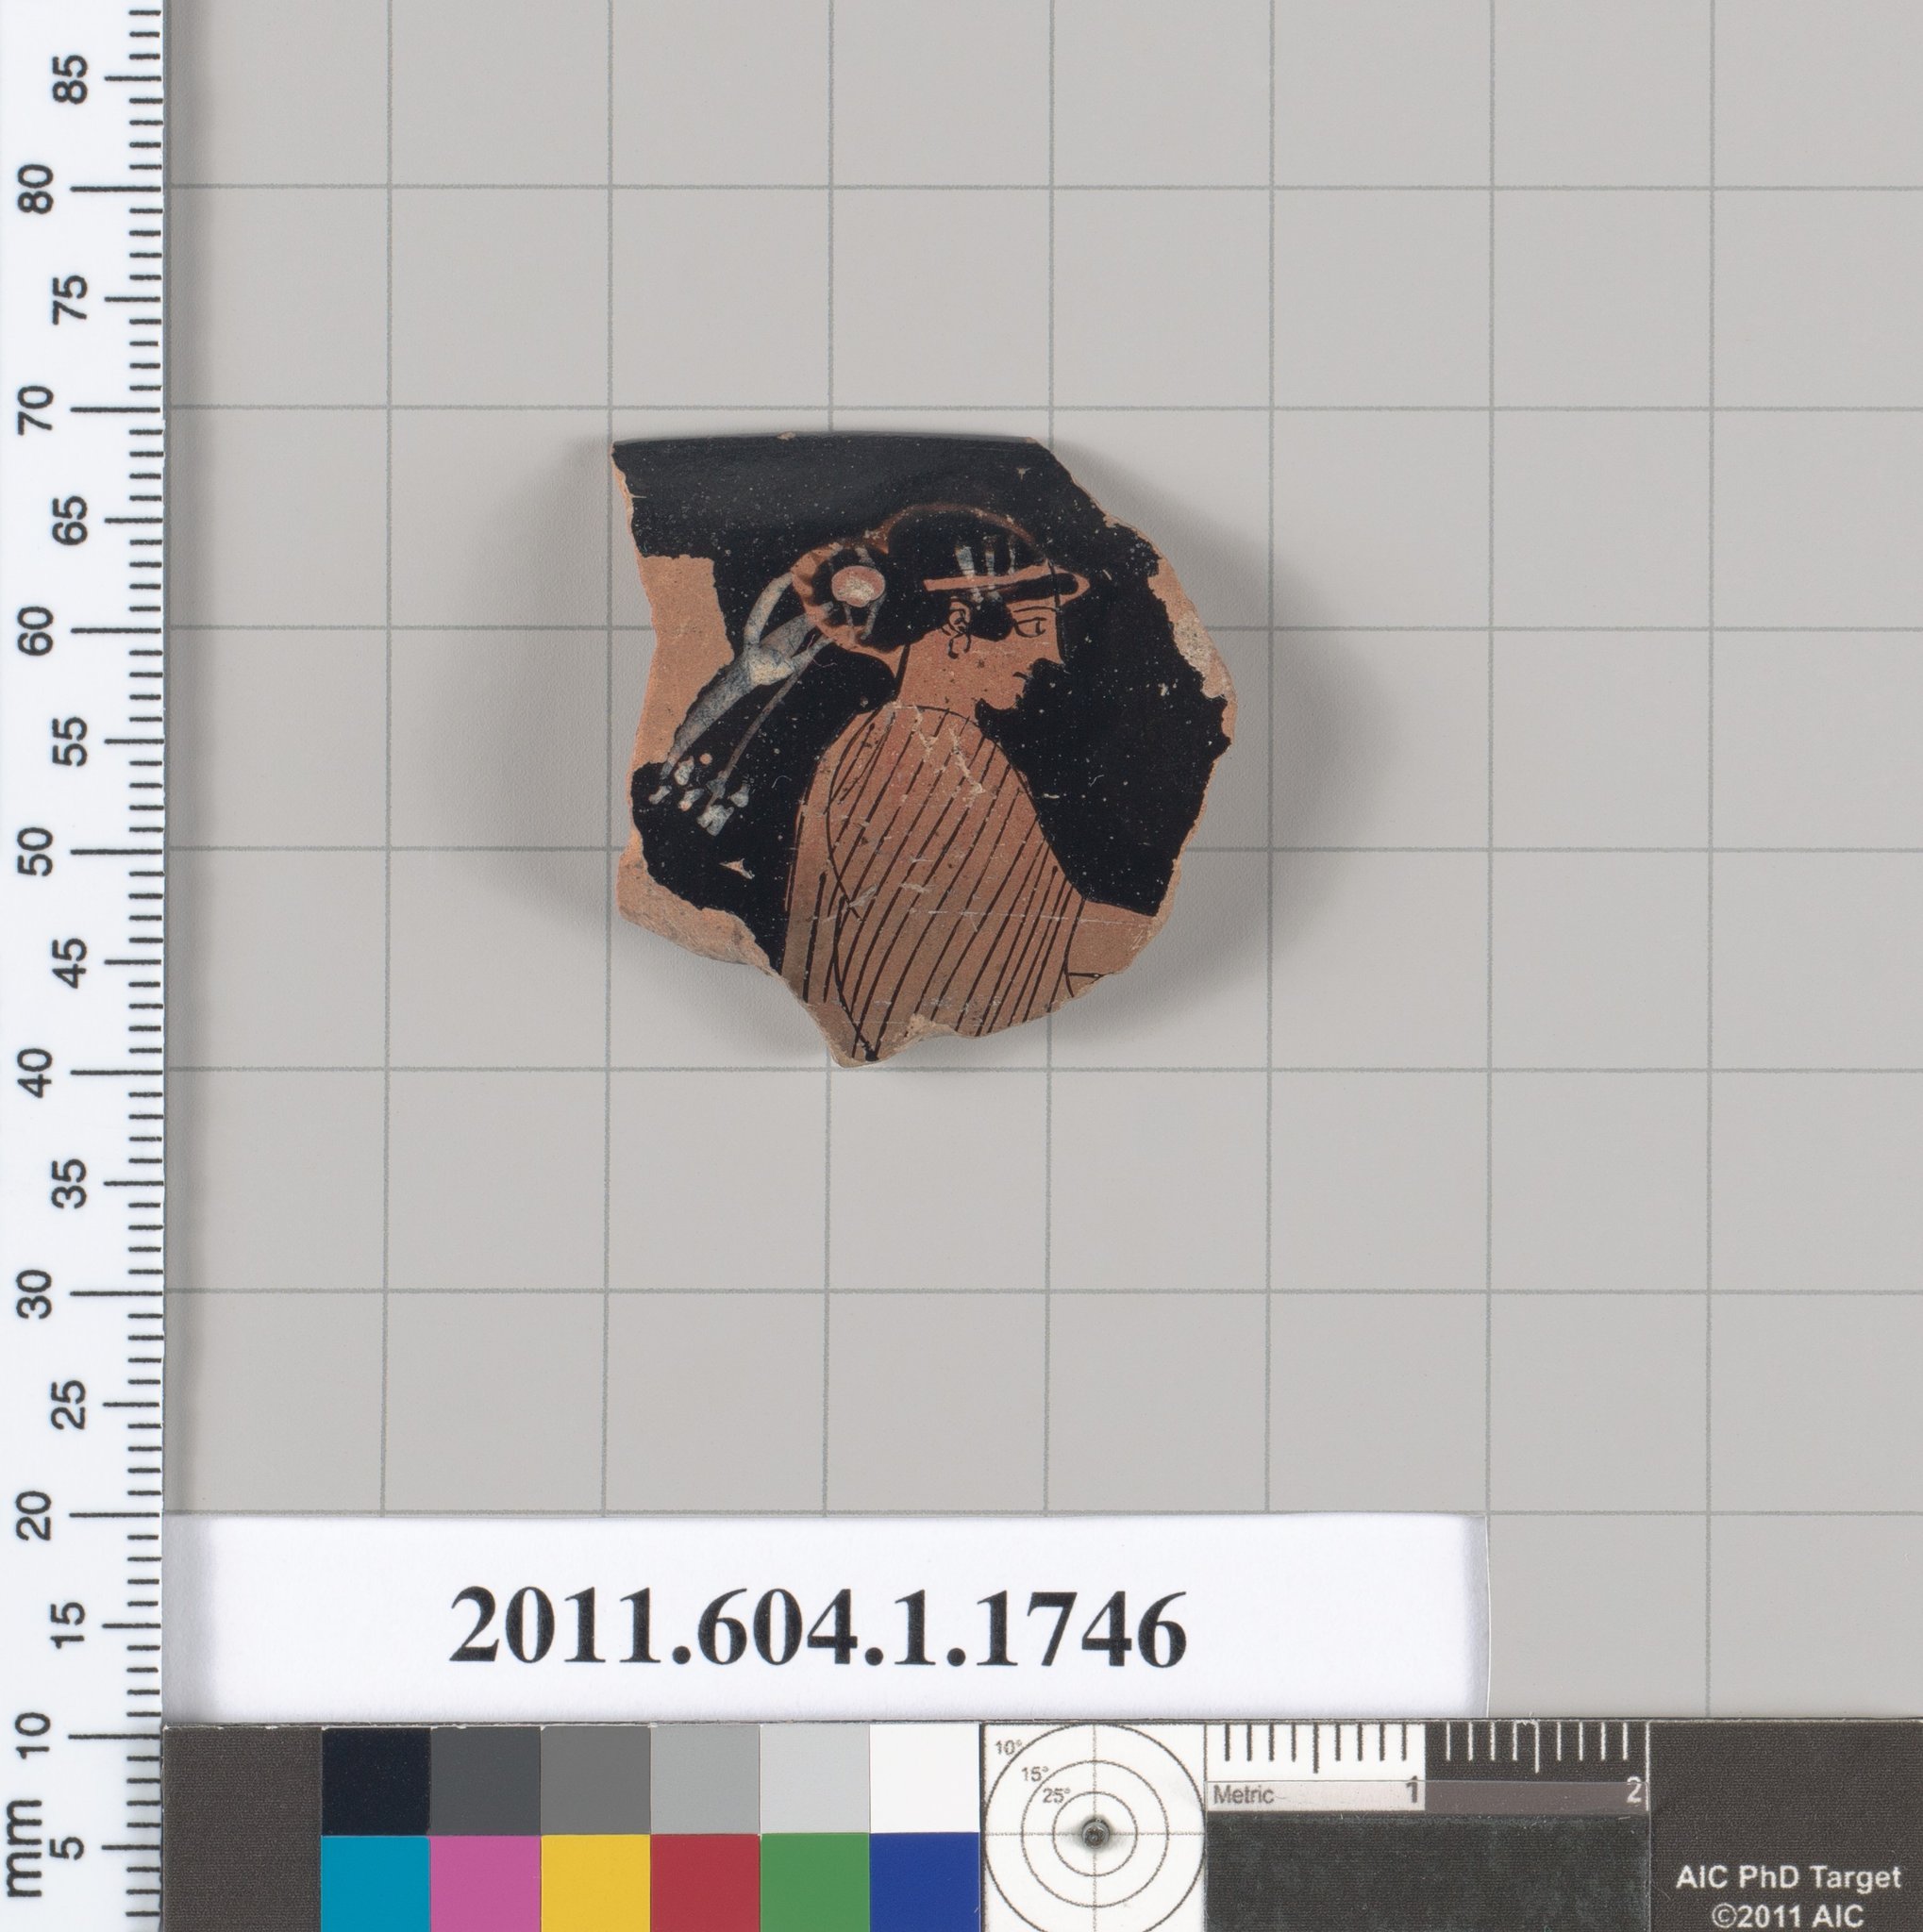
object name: kylix fragment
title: Terracotta rim fragment of a kylix (drinking cup)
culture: greek, attic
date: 475-451 BCE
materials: terracotta